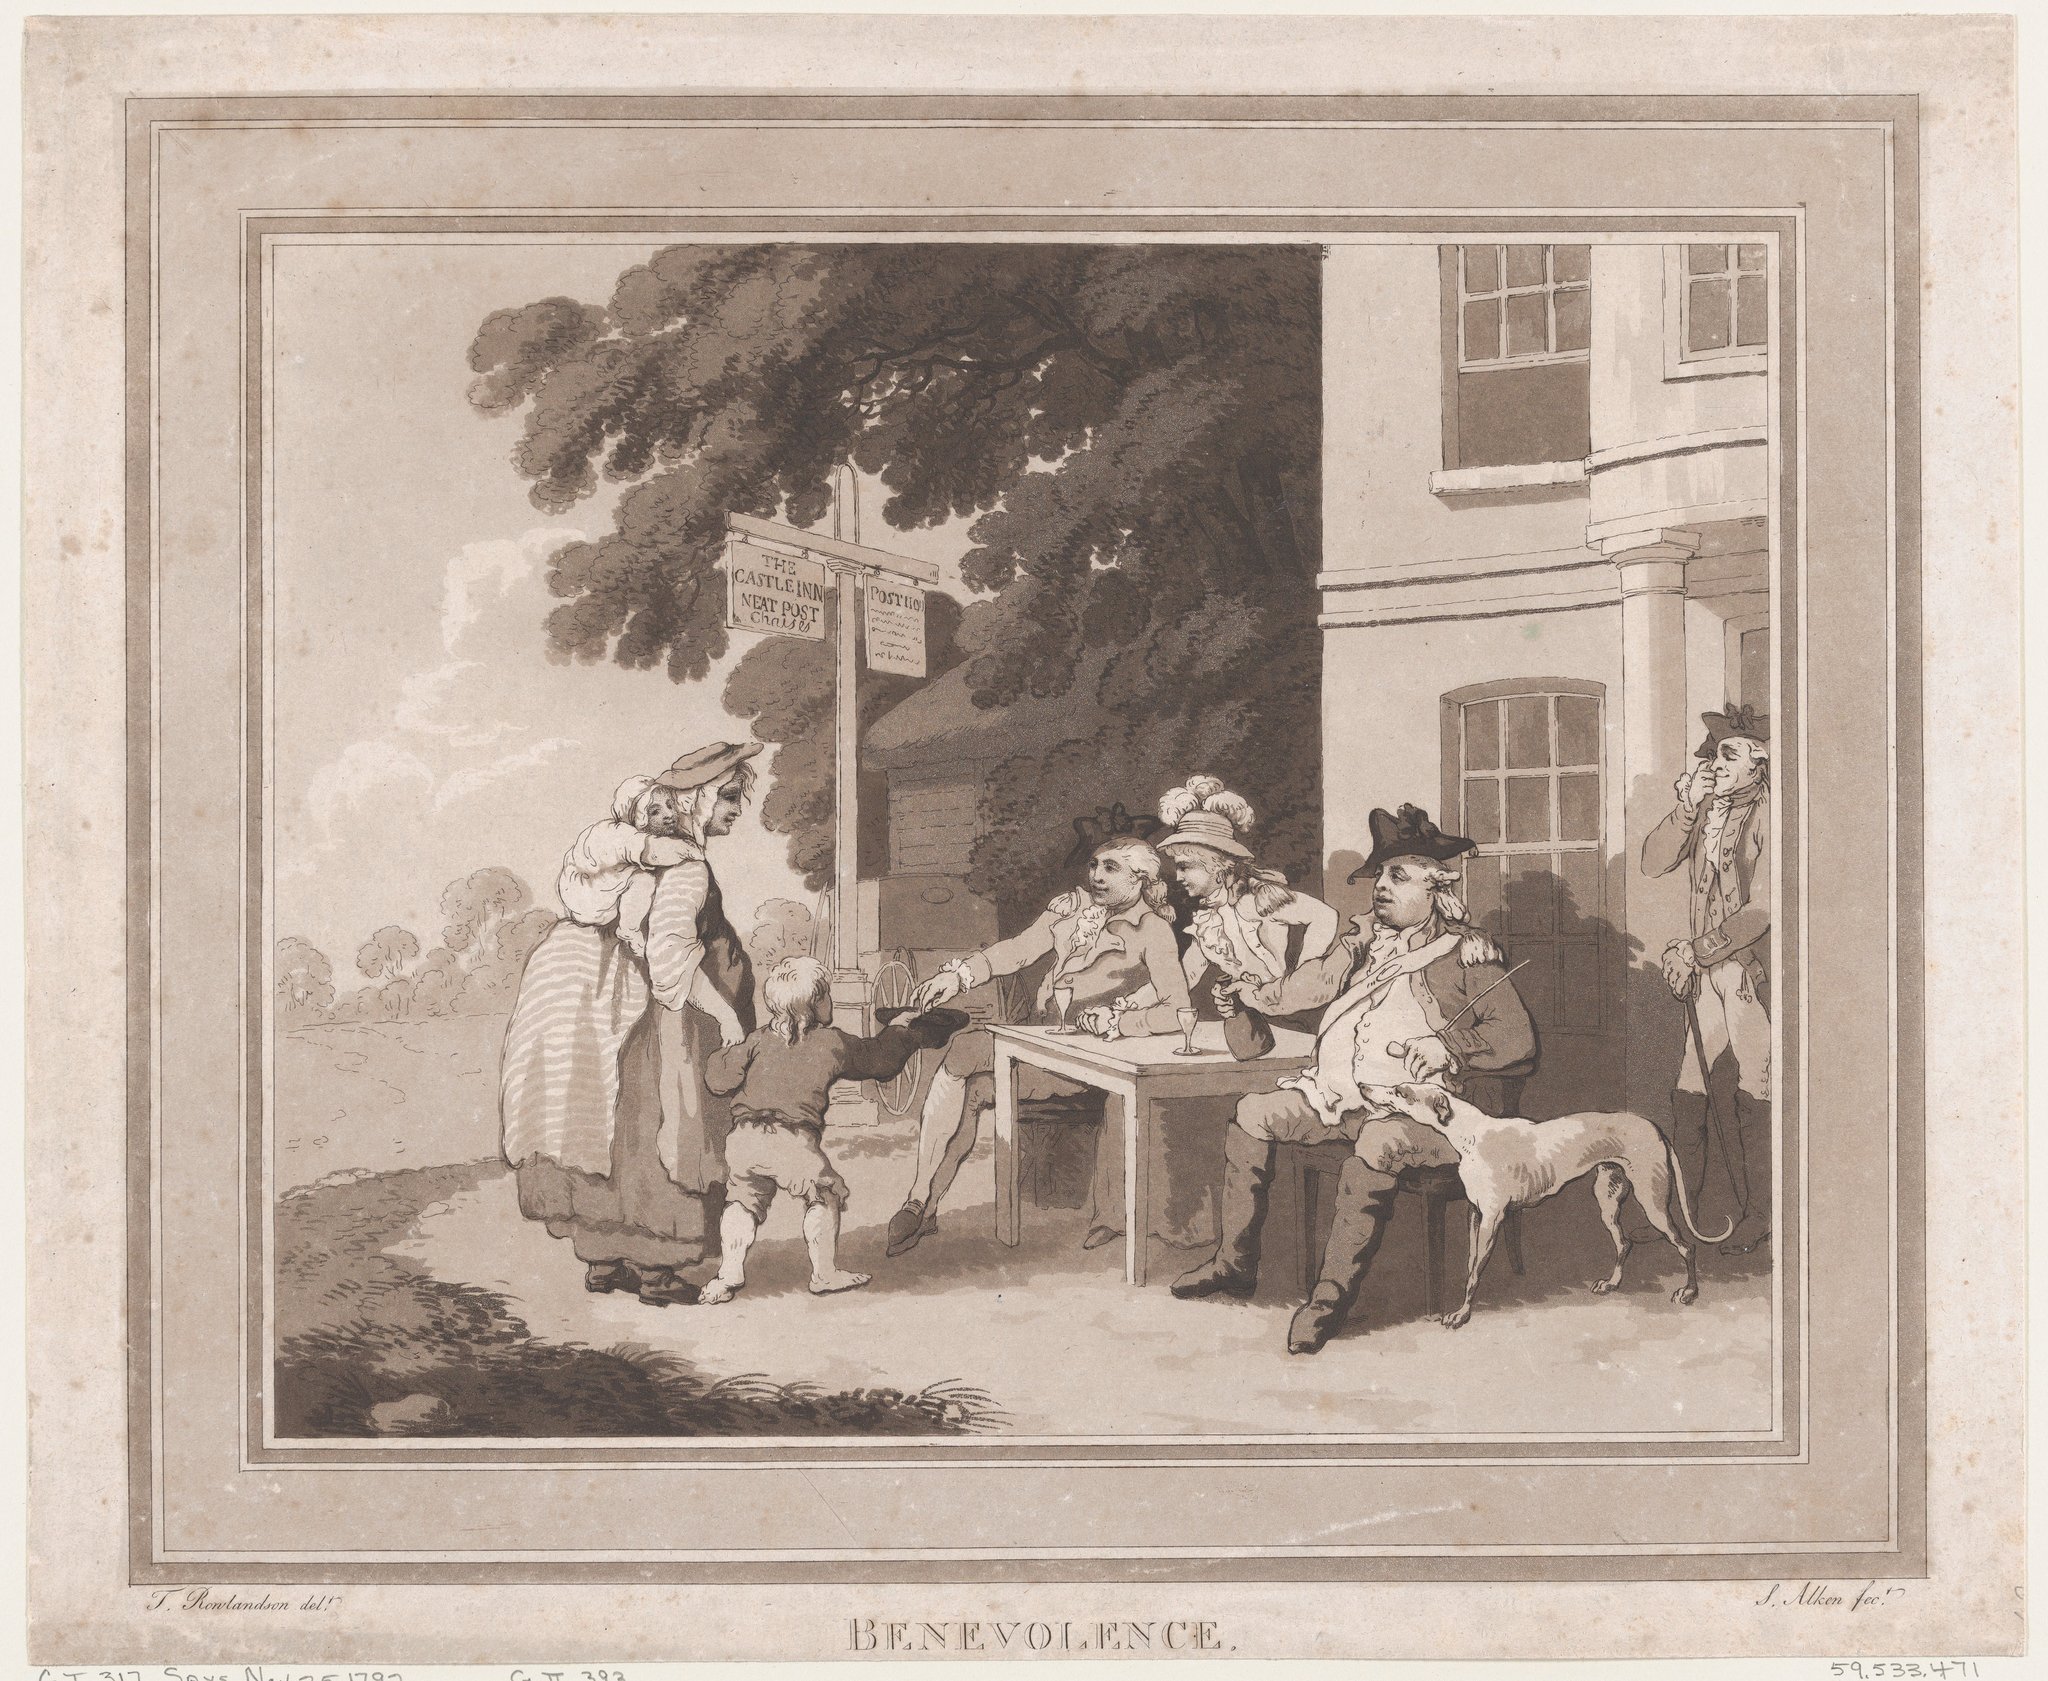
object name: print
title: Benevolence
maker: samuel alken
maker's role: etcher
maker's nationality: british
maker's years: 1756-1815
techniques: aquatint, etching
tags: children,men,women,dogs